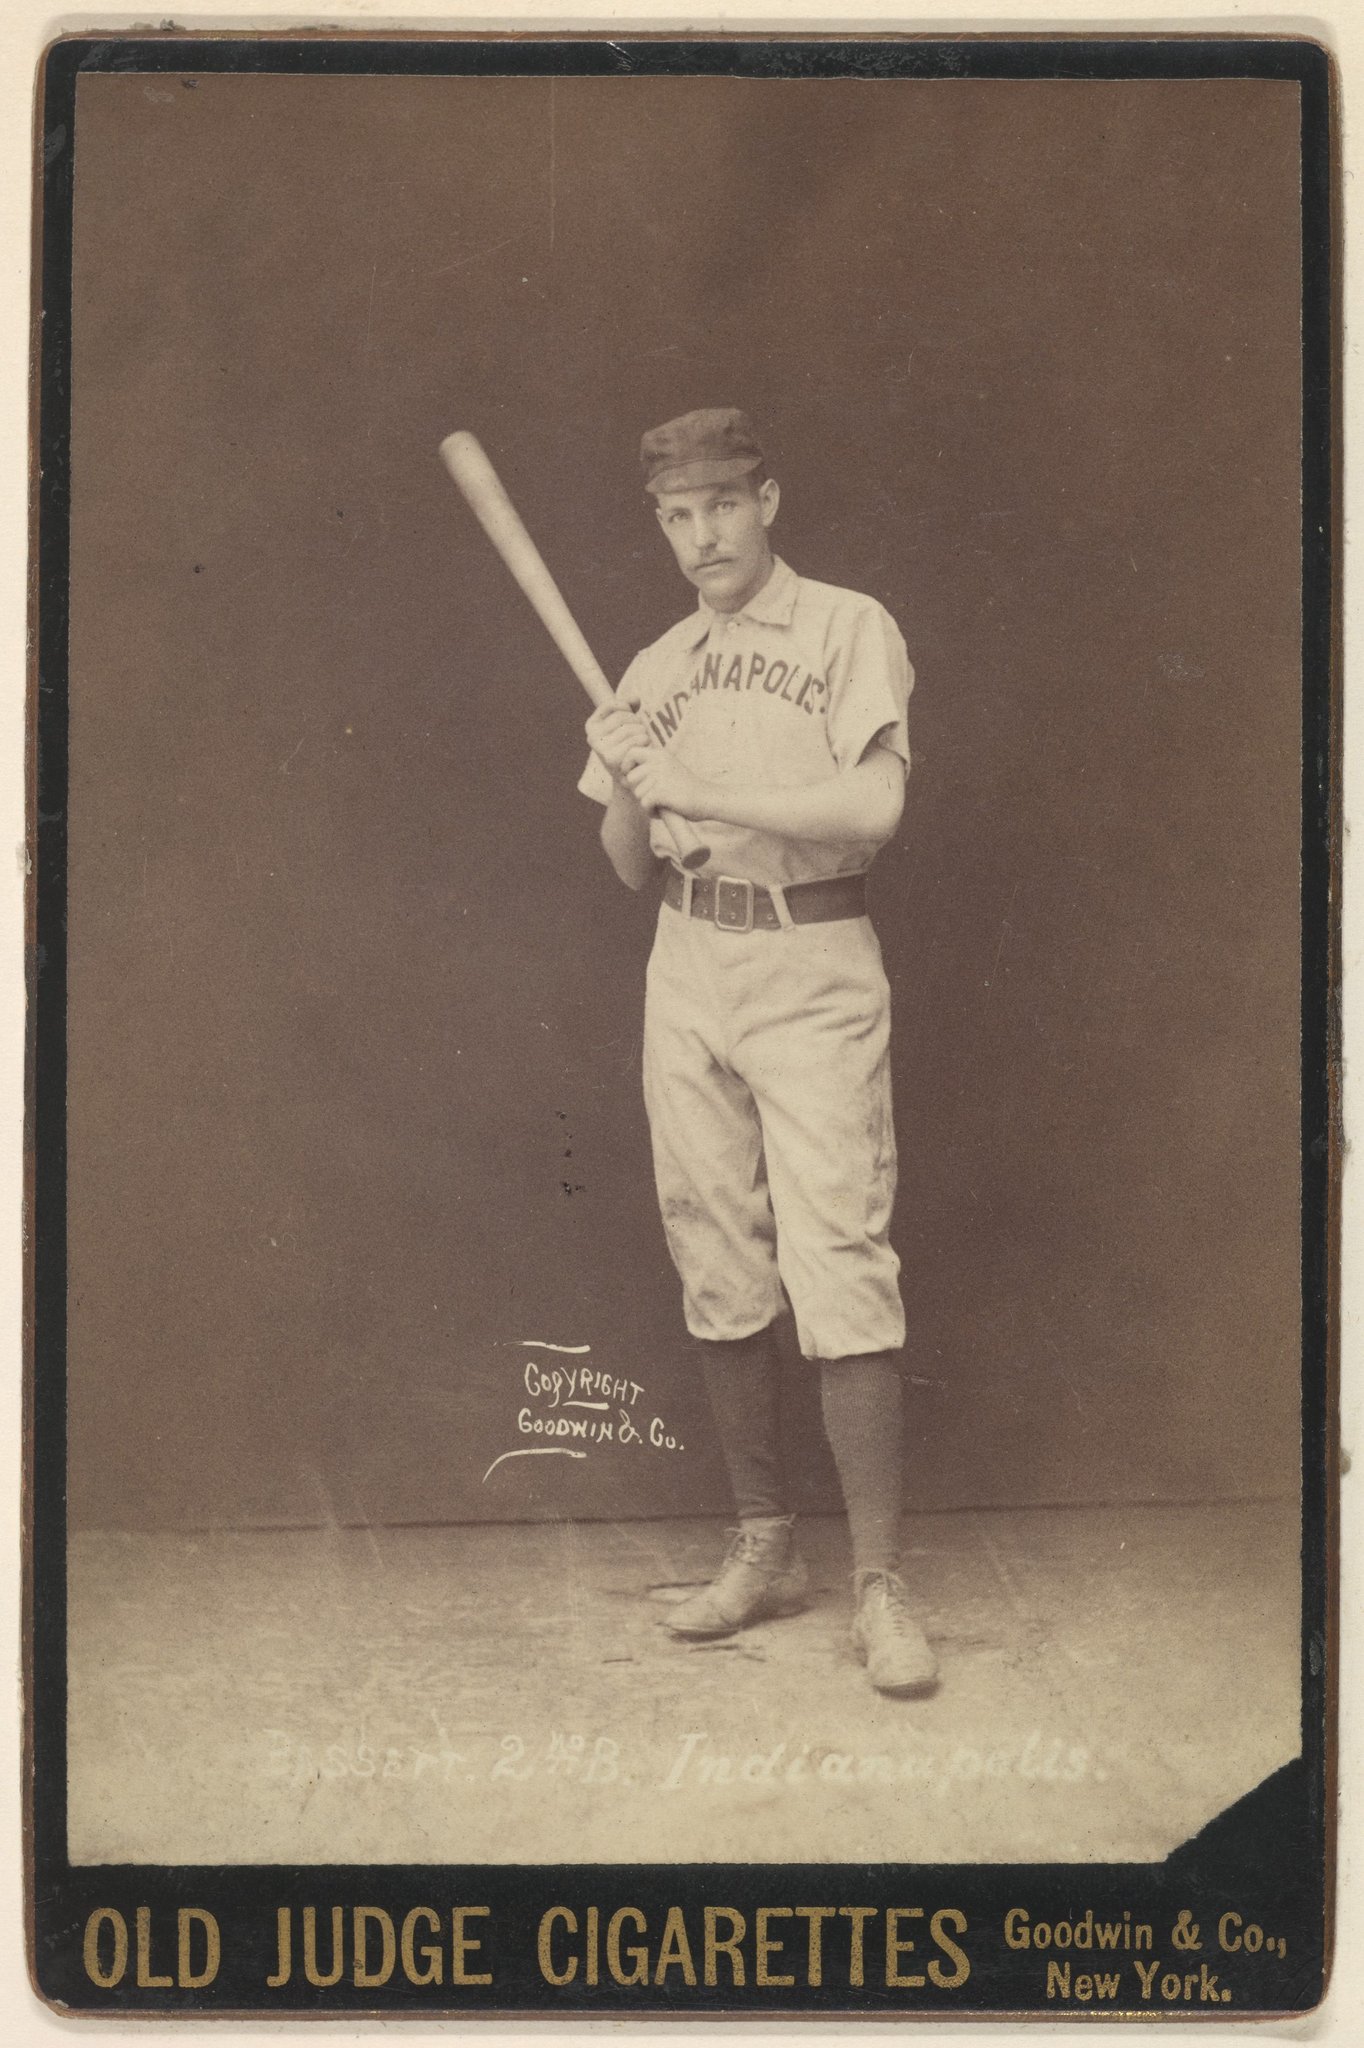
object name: baseball card, photograph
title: Charley Bassett, 2nd Base, Indianapolis, from the series Old Judge Cigarettes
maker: goodwin & company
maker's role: publisher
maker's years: 1850-1950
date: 1887-1889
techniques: albumen silver print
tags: men,portraits,baseball,athletes